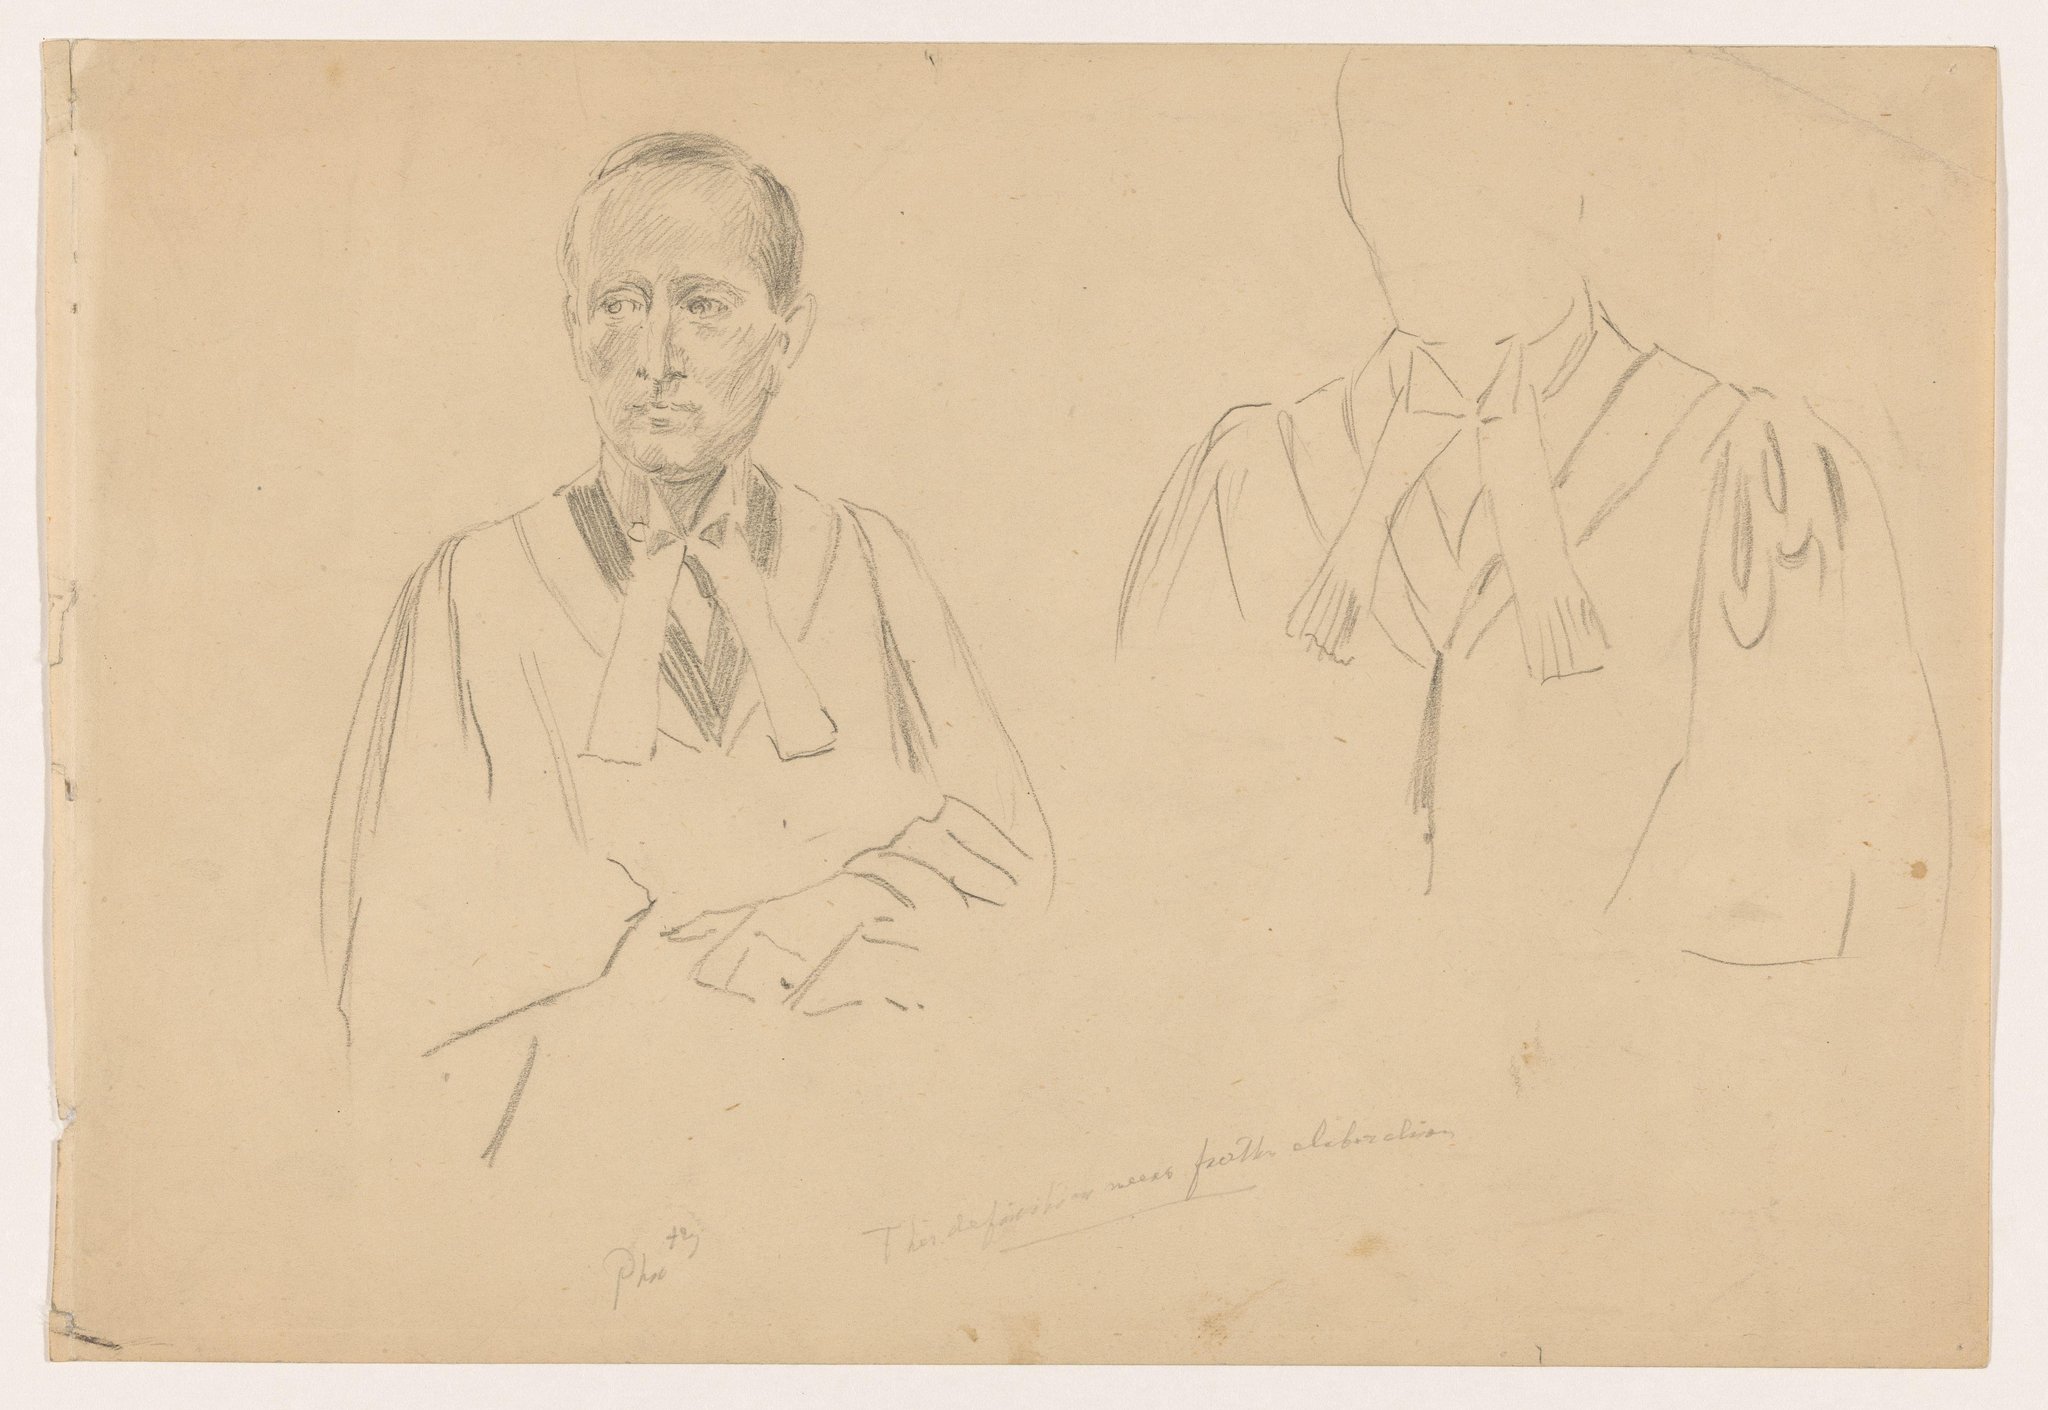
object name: drawing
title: Portretstudies voor het (onvoltooide) schilderij van de Nederlandse rechtbank in Londen, juni 1942: Mr C.W.A. Schürmann.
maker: anton abraham van anrooy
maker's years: 1870-1949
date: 1942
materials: paper, pencil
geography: westminster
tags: london, anton abraham van anrooy, historical persons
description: Voortekening uit een serie van 11 studies. Twee schetsen van portret van Mr C.W.A. Schürmann, de waarnemend-officier van justitie van de rechtbank. Achterkant: opzet van indeling van het schilderij. Met opschrift.